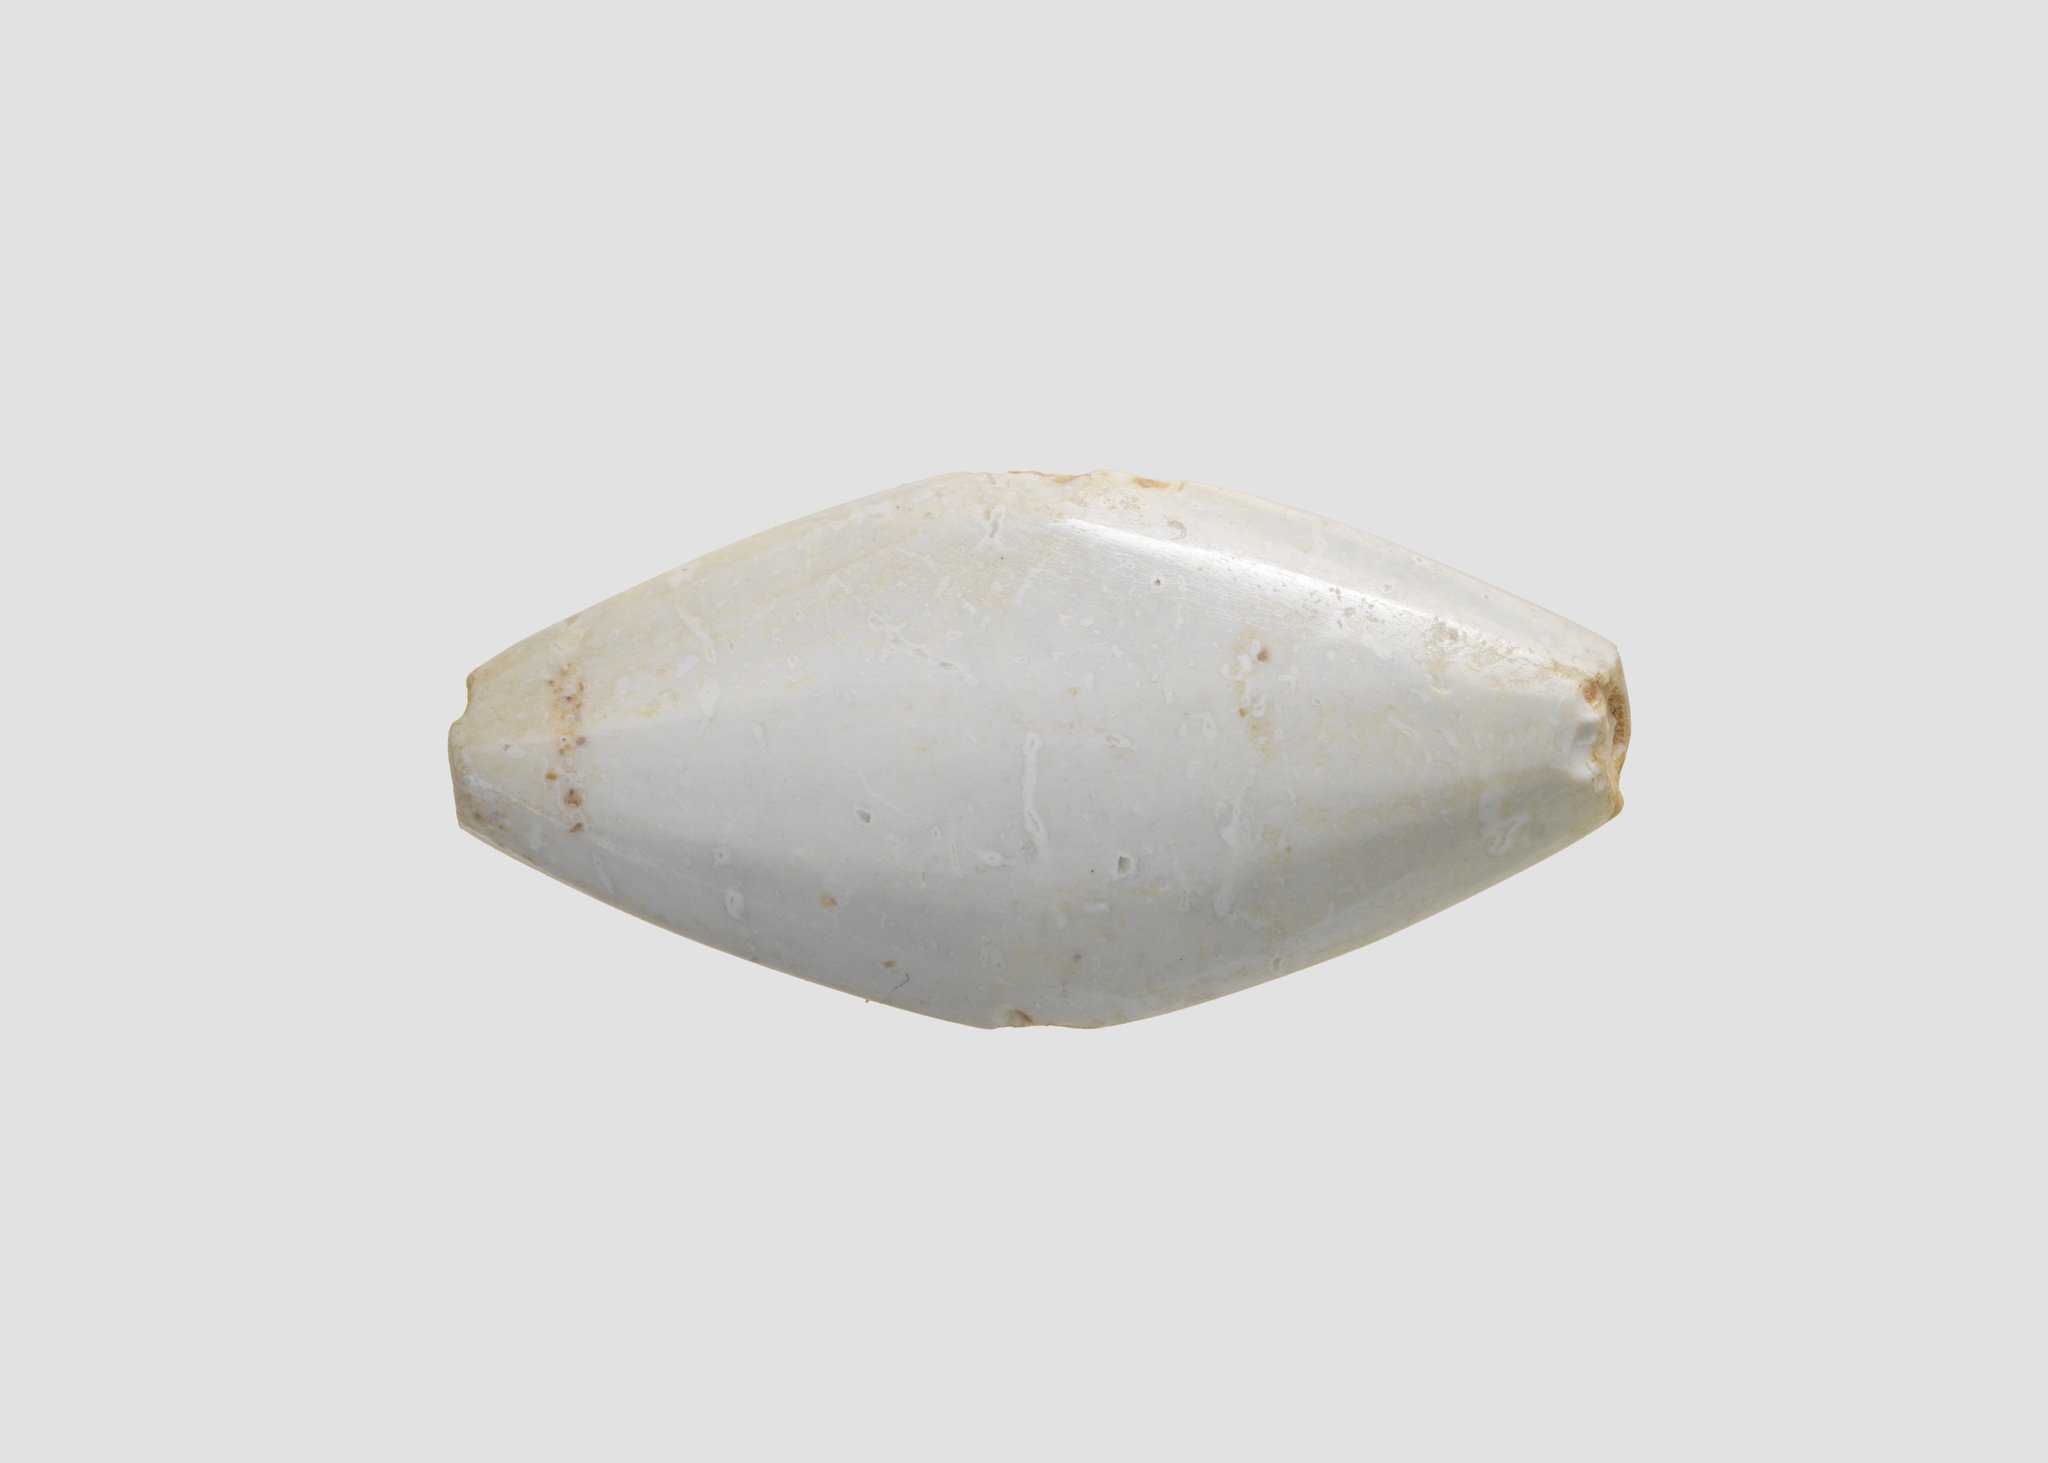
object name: bead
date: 7333-7001 BCE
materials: stone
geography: syria